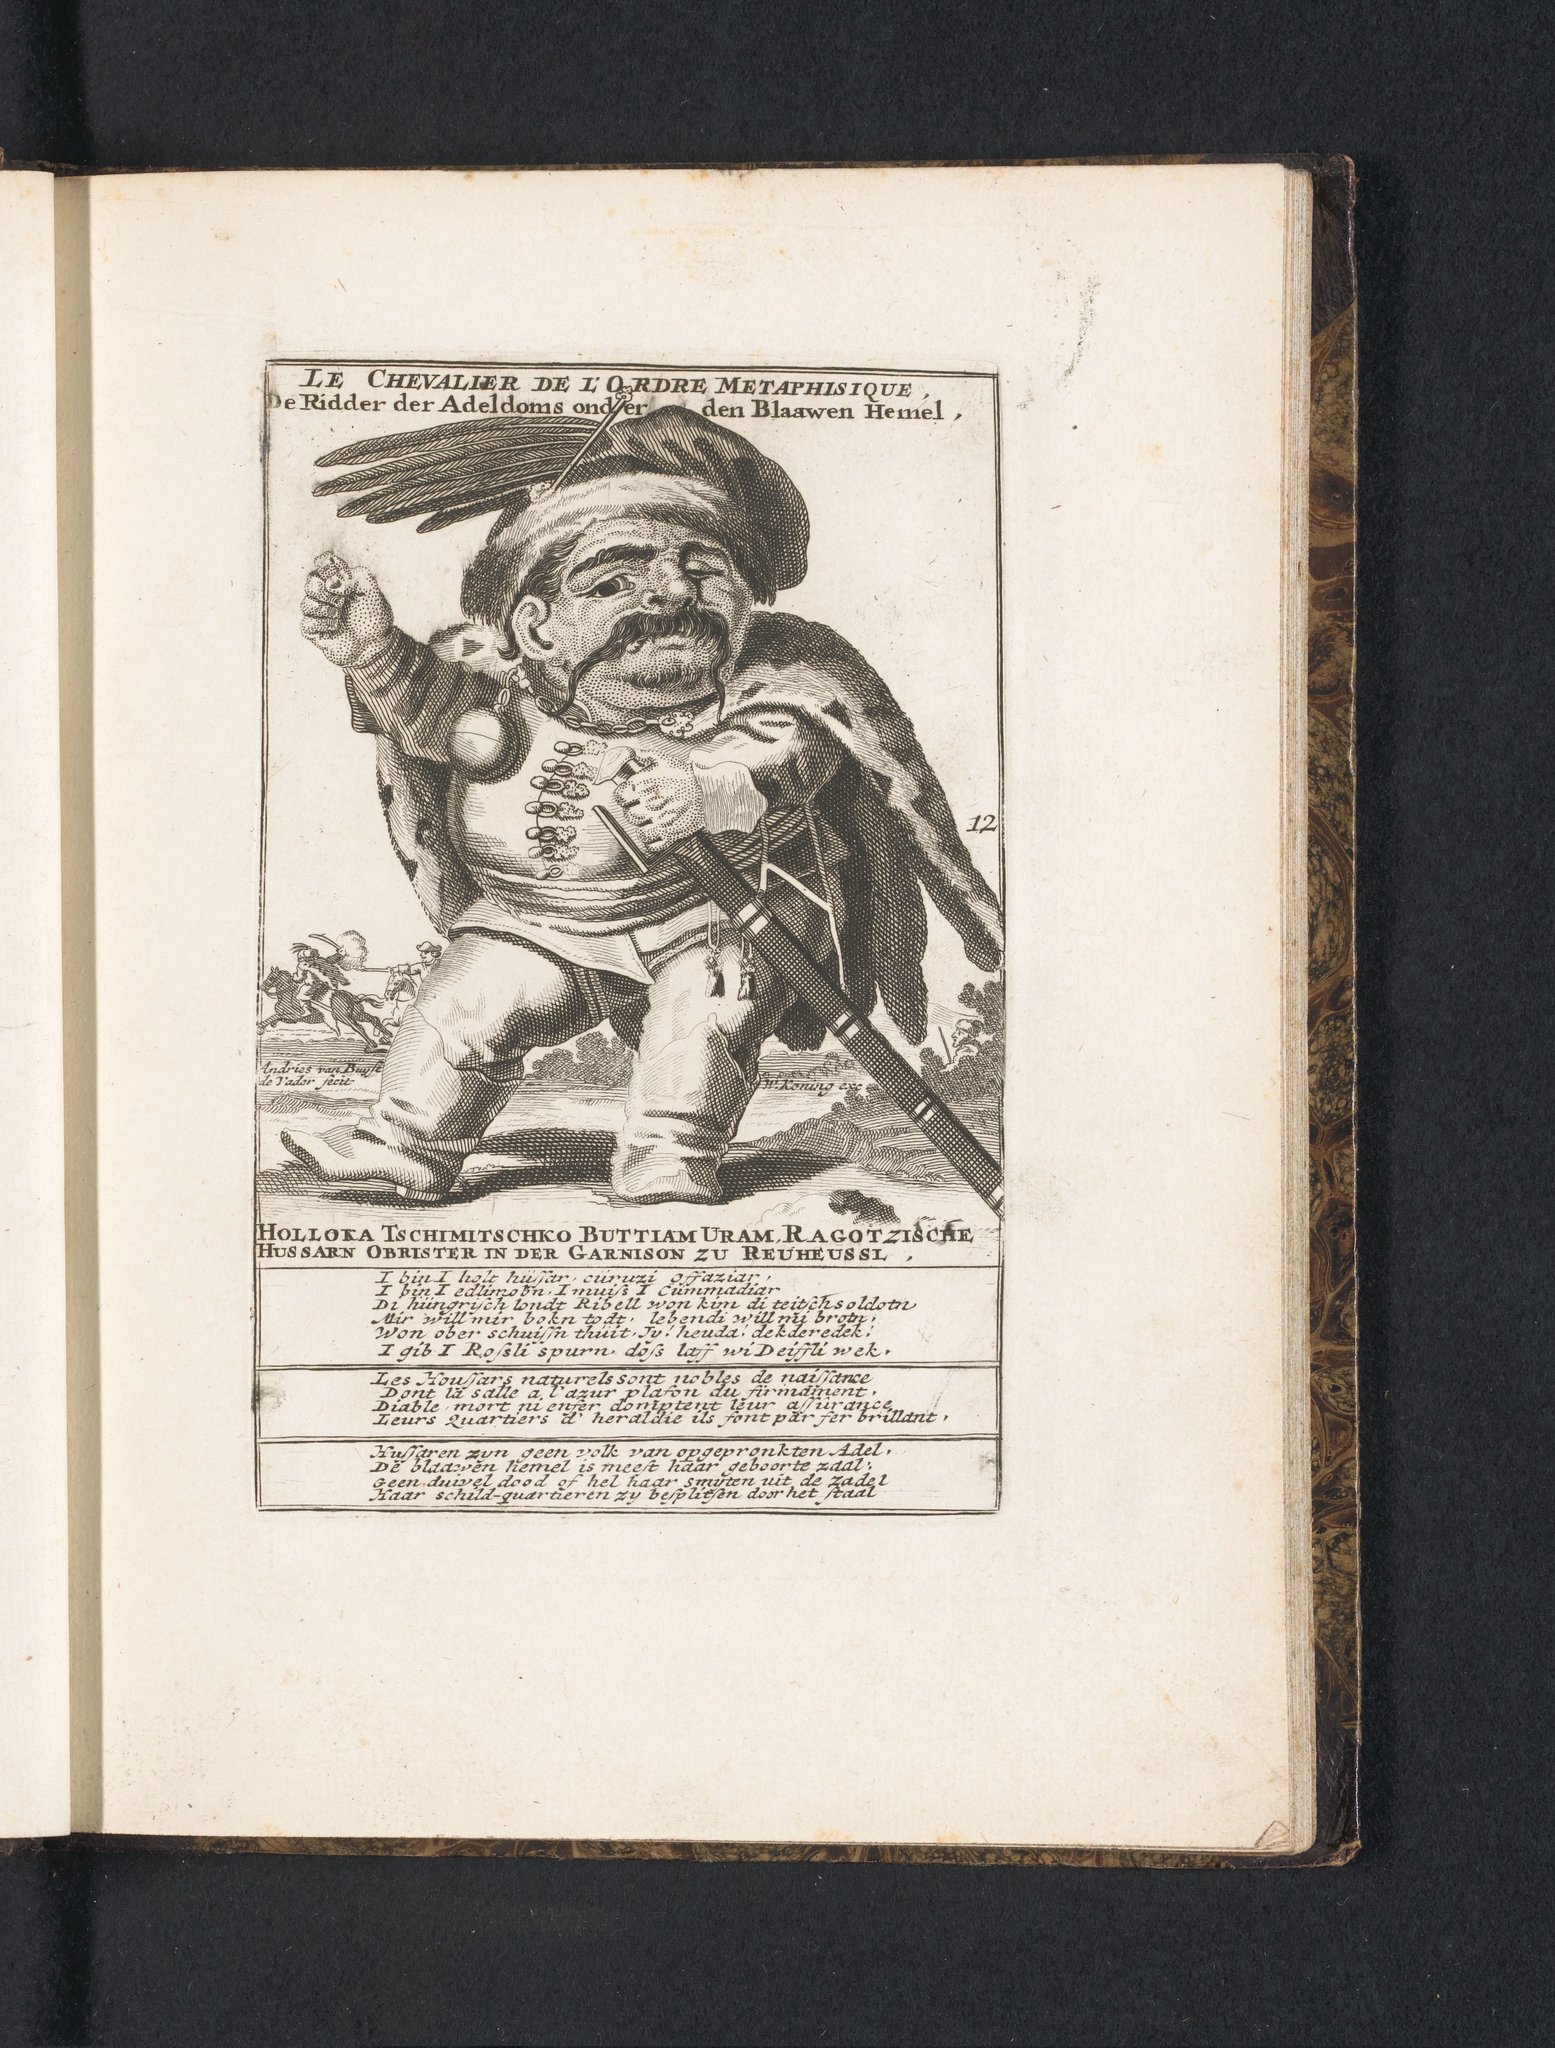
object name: print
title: De dwerg Ridder der Adeldoms als huzaar, 1720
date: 1718-1720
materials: paper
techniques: etching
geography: northern netherlands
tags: caricatures (human types), little people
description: De kleine mens Ridder der Adeldoms als huzaar. In het onderschrift verzen in het Duits, Frans en Nederlands. Genummerd rechts midden: 12. Onderdeel van de tweede Nederlandse gebonden uitgave uit 1720 (en gerelateerd aan de Windhandel in dat jaar) van een serie karikaturen van kleine mensen, bekend als Het Dwergentooneel.